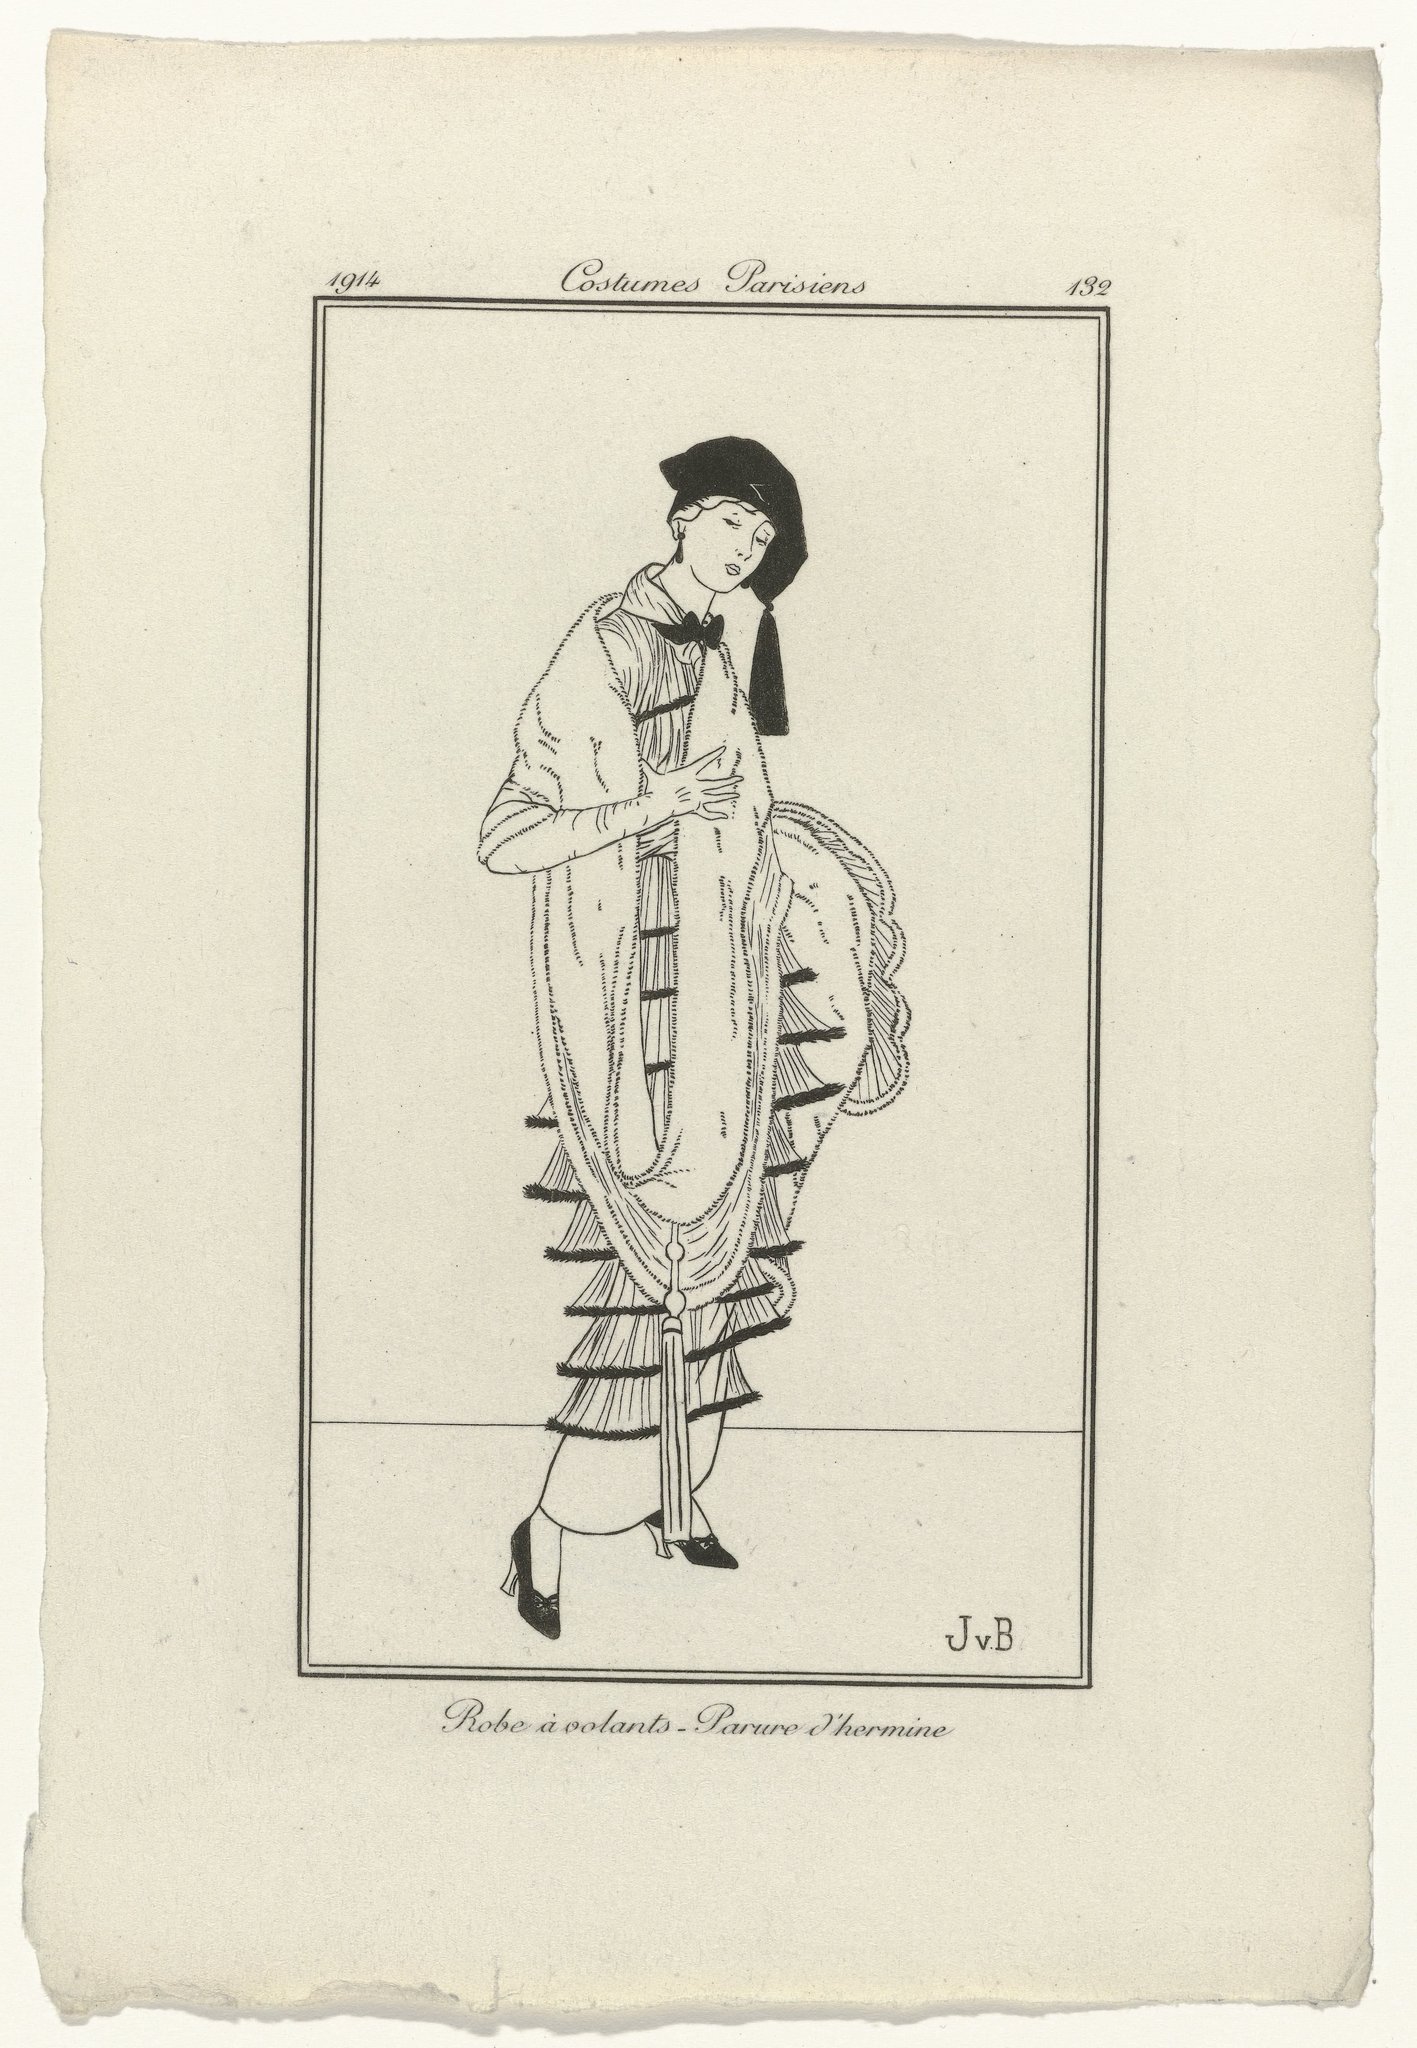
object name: fashion print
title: Journal des Dames et des Modes, Costumes Parisiens, 1914, No. 132 : Robe à volants - (...)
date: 1914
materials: paper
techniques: engraving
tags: head-gear (+ women's clothes), fashion plates, dress, gown (+ women's clothes), clothing for the upper part of the body (shawl) (+ fur used for clothes)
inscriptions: title: ‘Costumes Parisiens’, caption: ‘Robe à volants - Parure d'hermine’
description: Vrouw gekleed in een japon met geplooide stroken stof. 'Parure' van hermelijn. Pumps met rode hakken. Proefdruk van een prent uit het modetijdschrift Journal des Dames et des Modes (1912-1914).